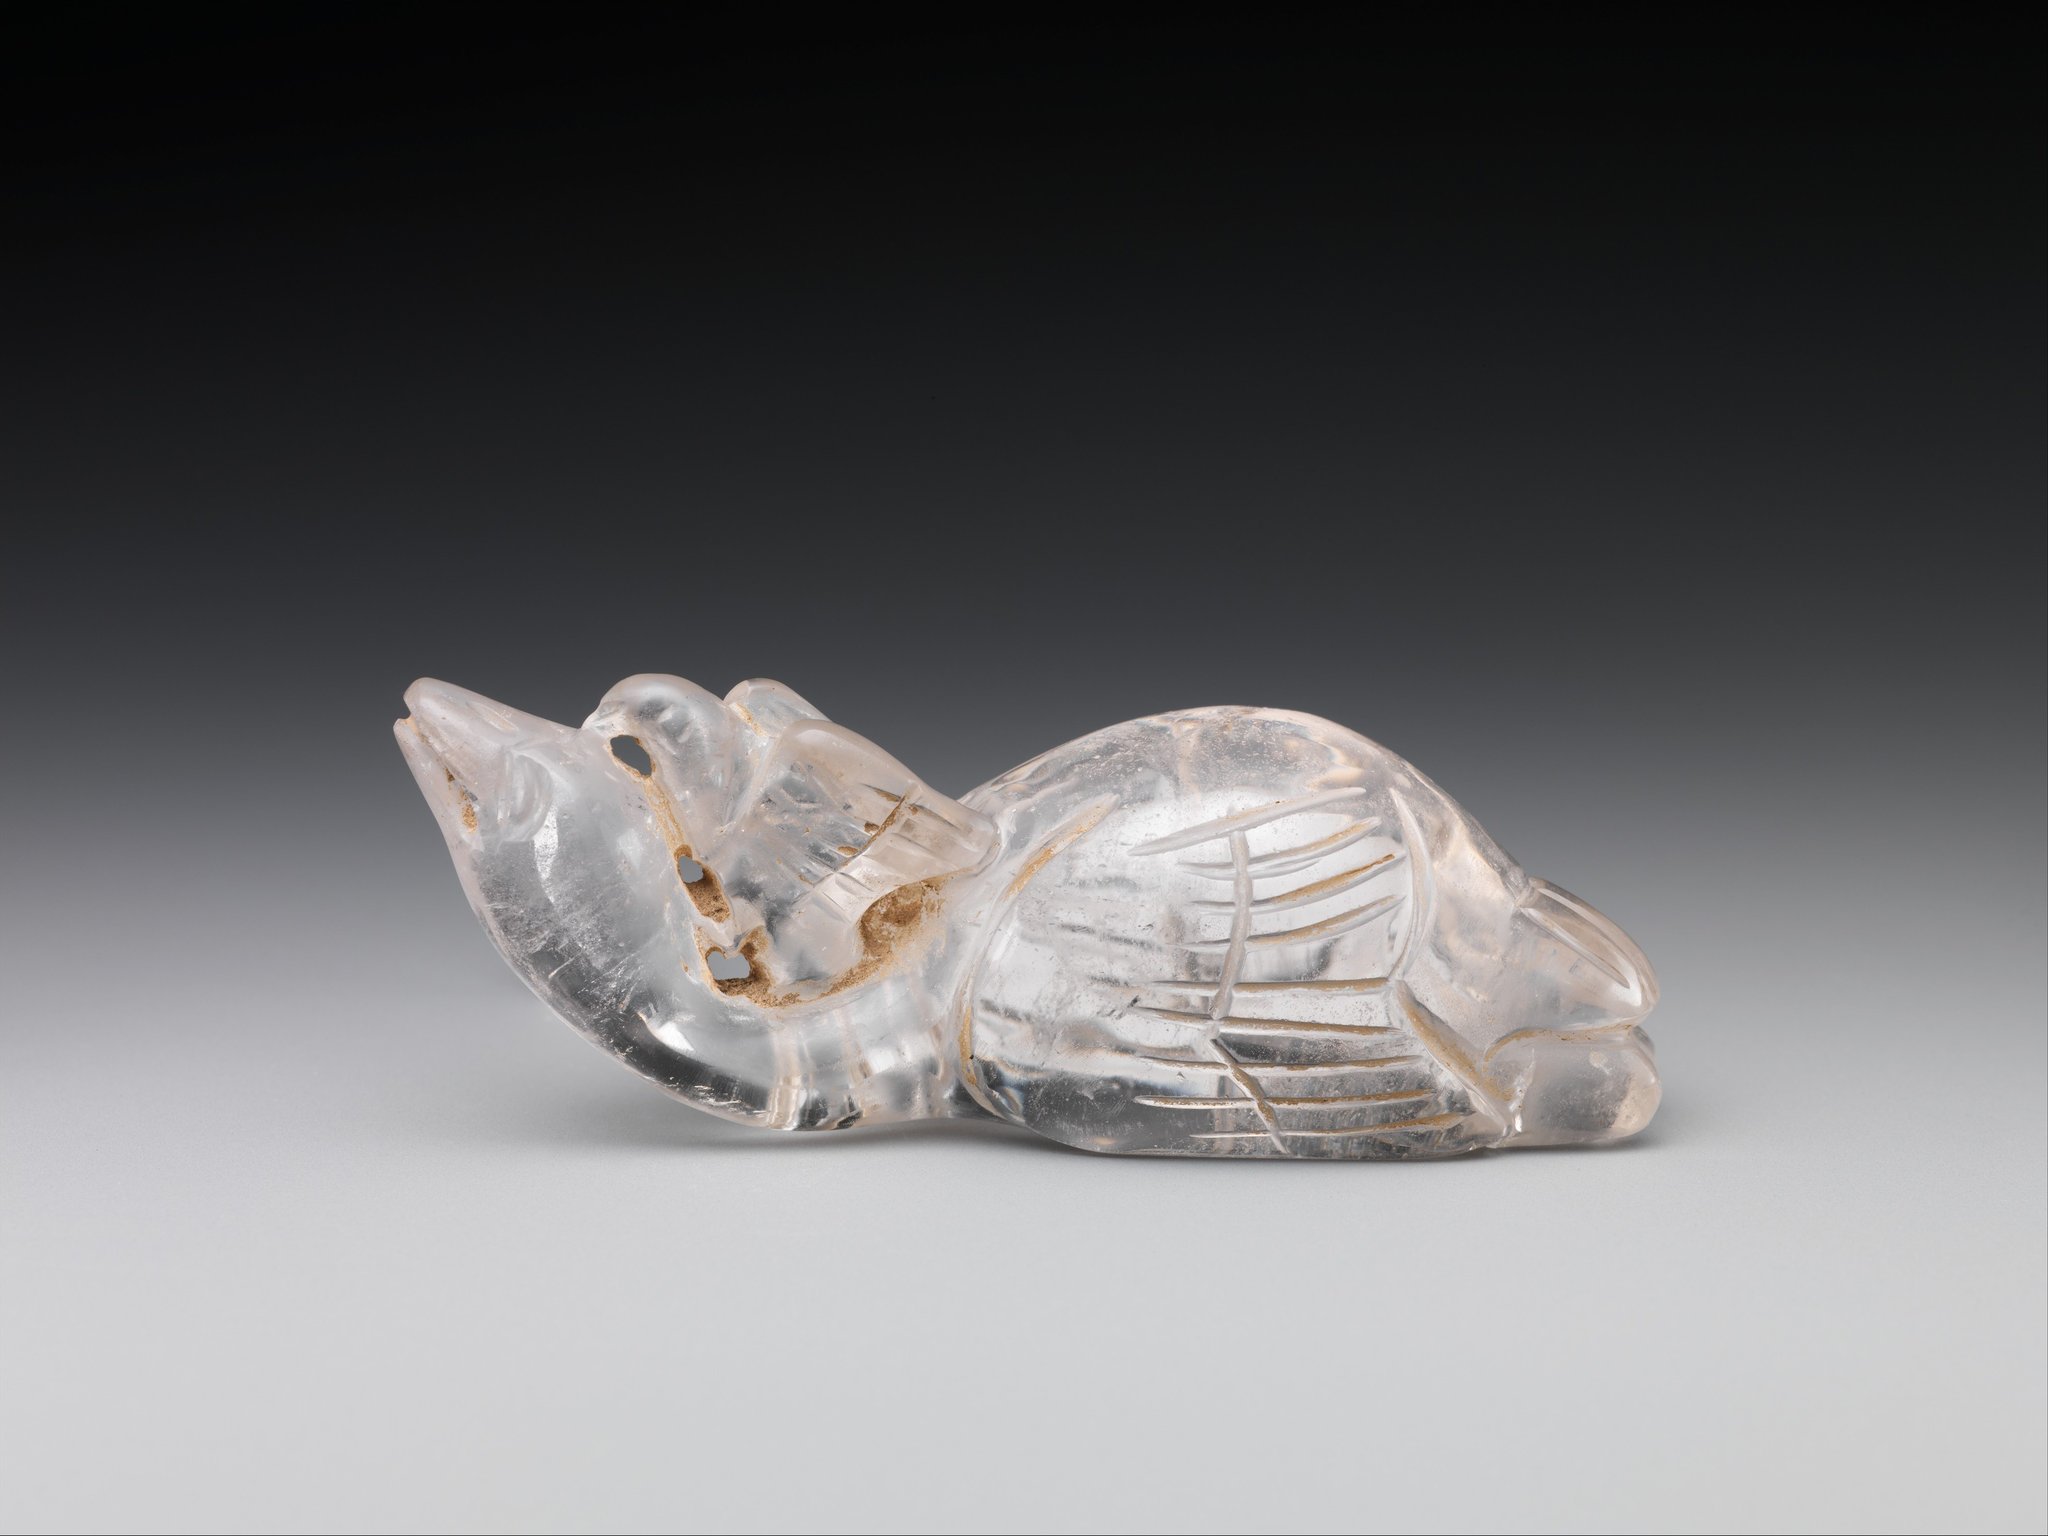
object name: toggle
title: Toggle in the shape of a falcon attacking a swan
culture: chinese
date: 901-1100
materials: crystal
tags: hawks,swans